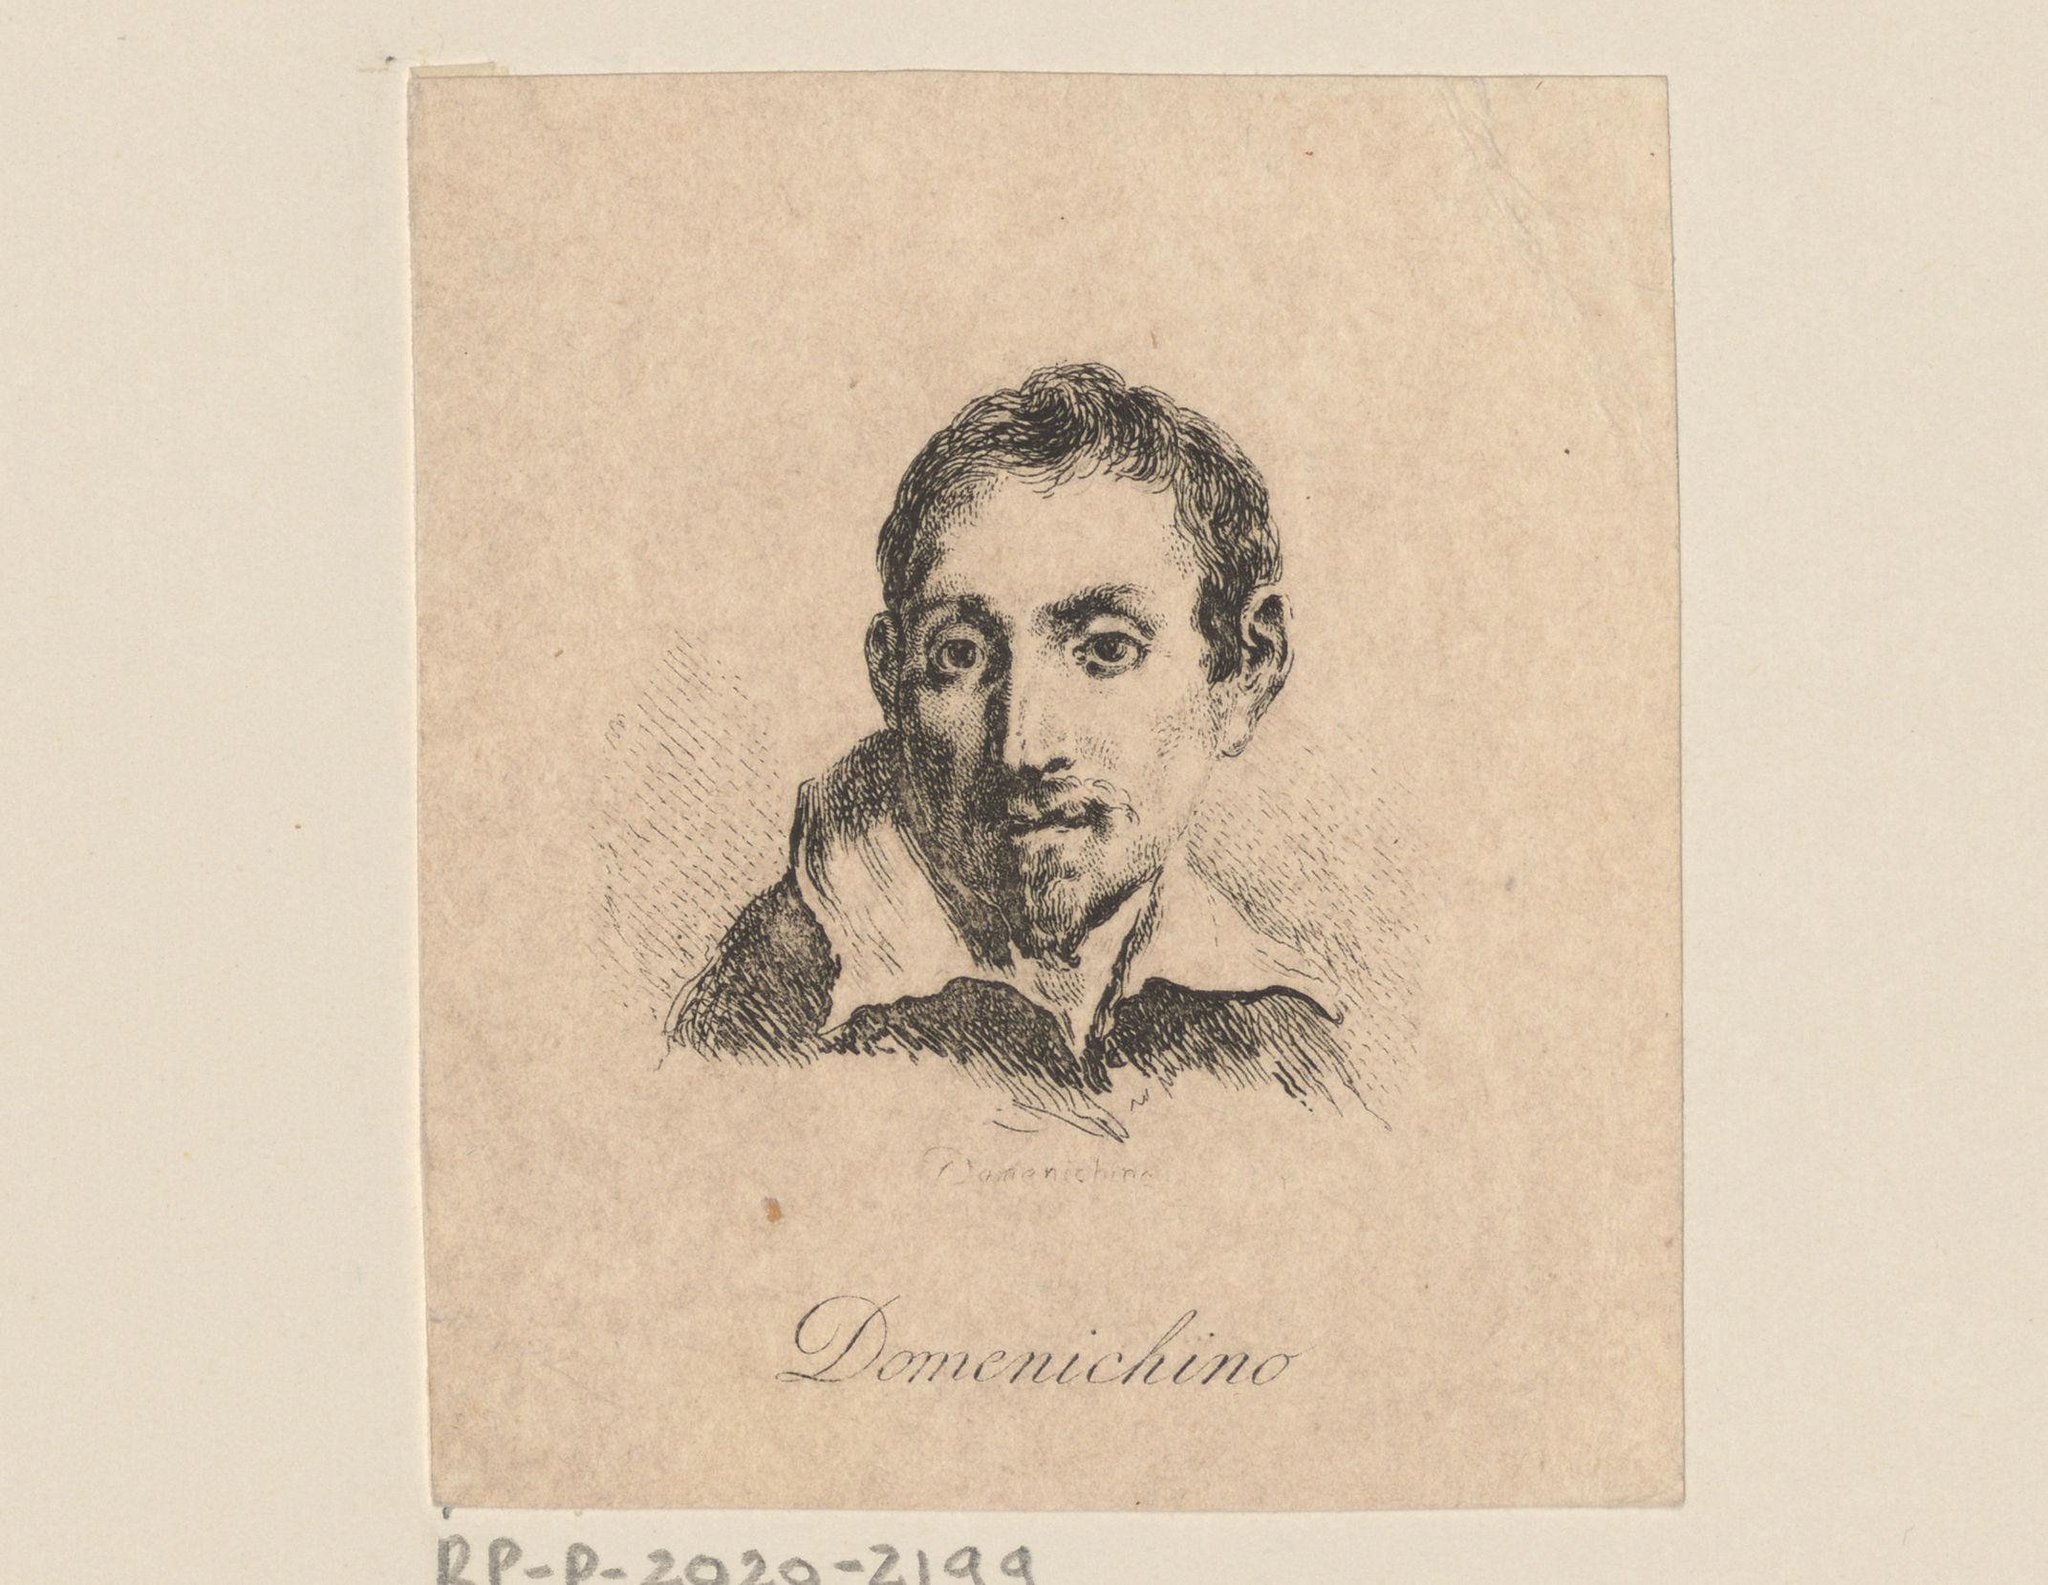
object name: print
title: Portret van Domenichino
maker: francesco novelli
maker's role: draughtsman, painter, print maker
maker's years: 1767-1836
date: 1779-1836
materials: paper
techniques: engraving, etching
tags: naples, domenichino, historical persons, portrait, self-portrait of painter, portrait, self-portrait of artist